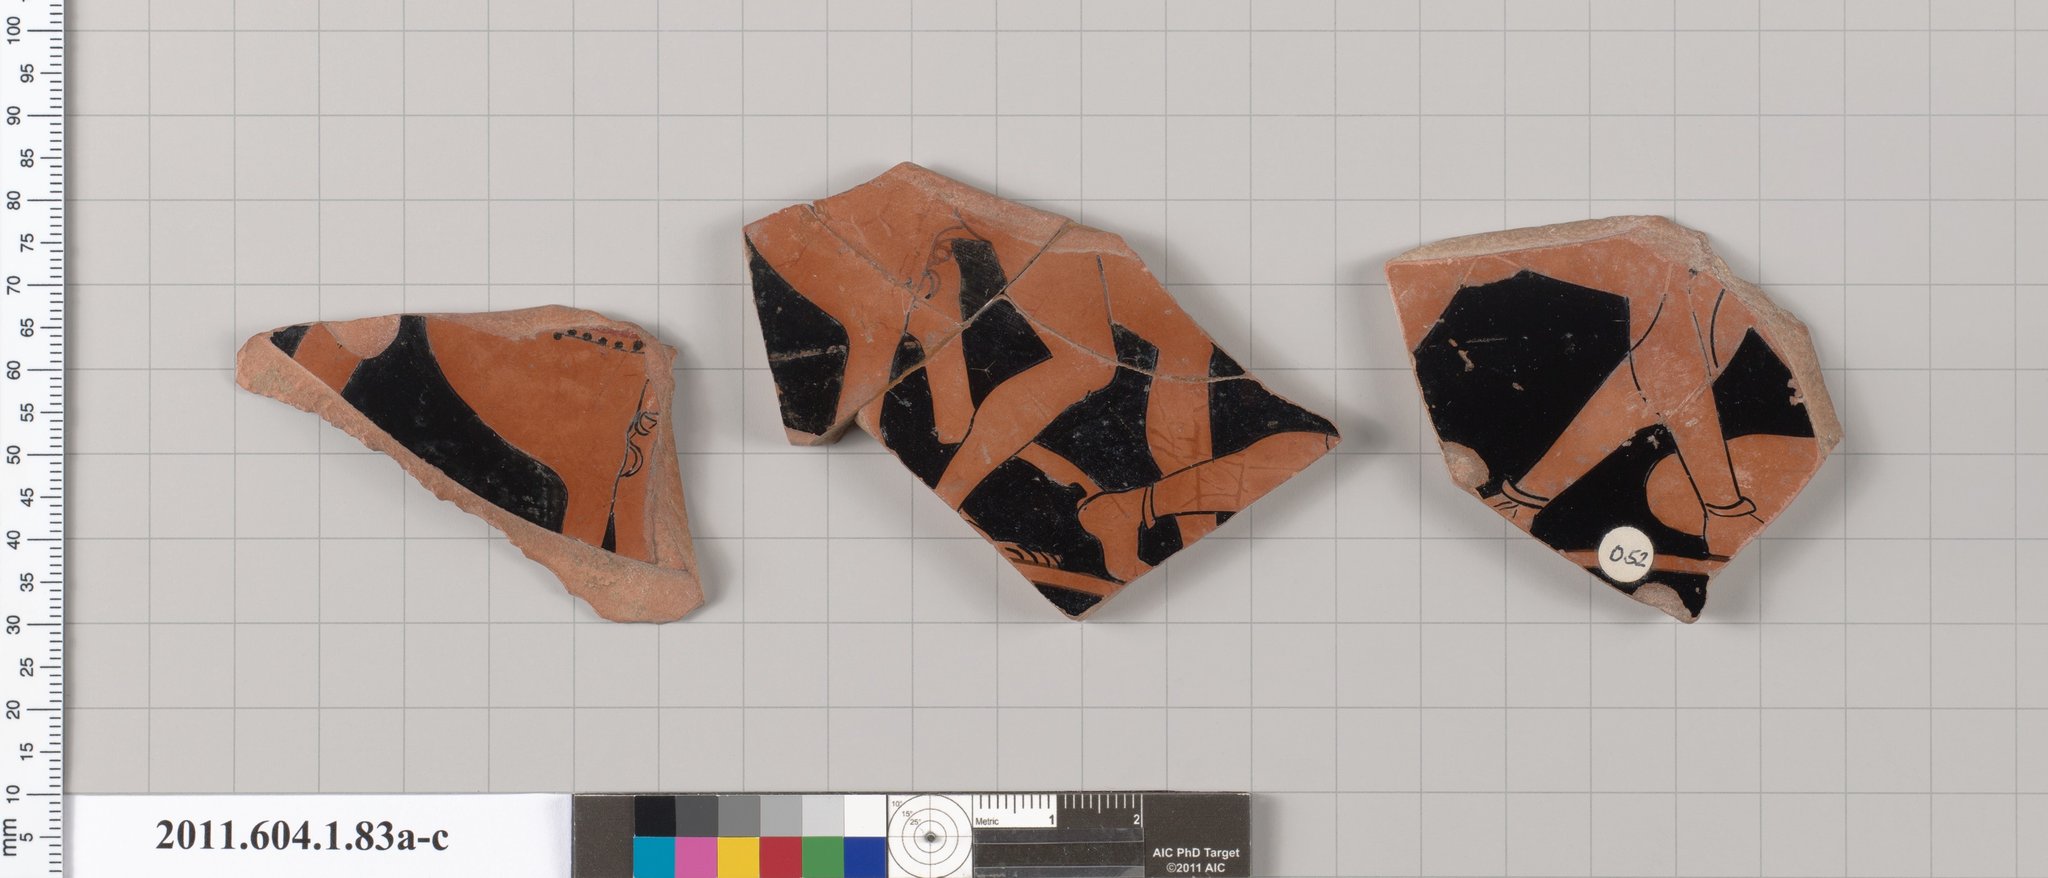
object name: kylix fragment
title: Terracotta fragments of a kylix (drinking cup)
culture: greek, attic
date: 520-500 BCE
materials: terracotta